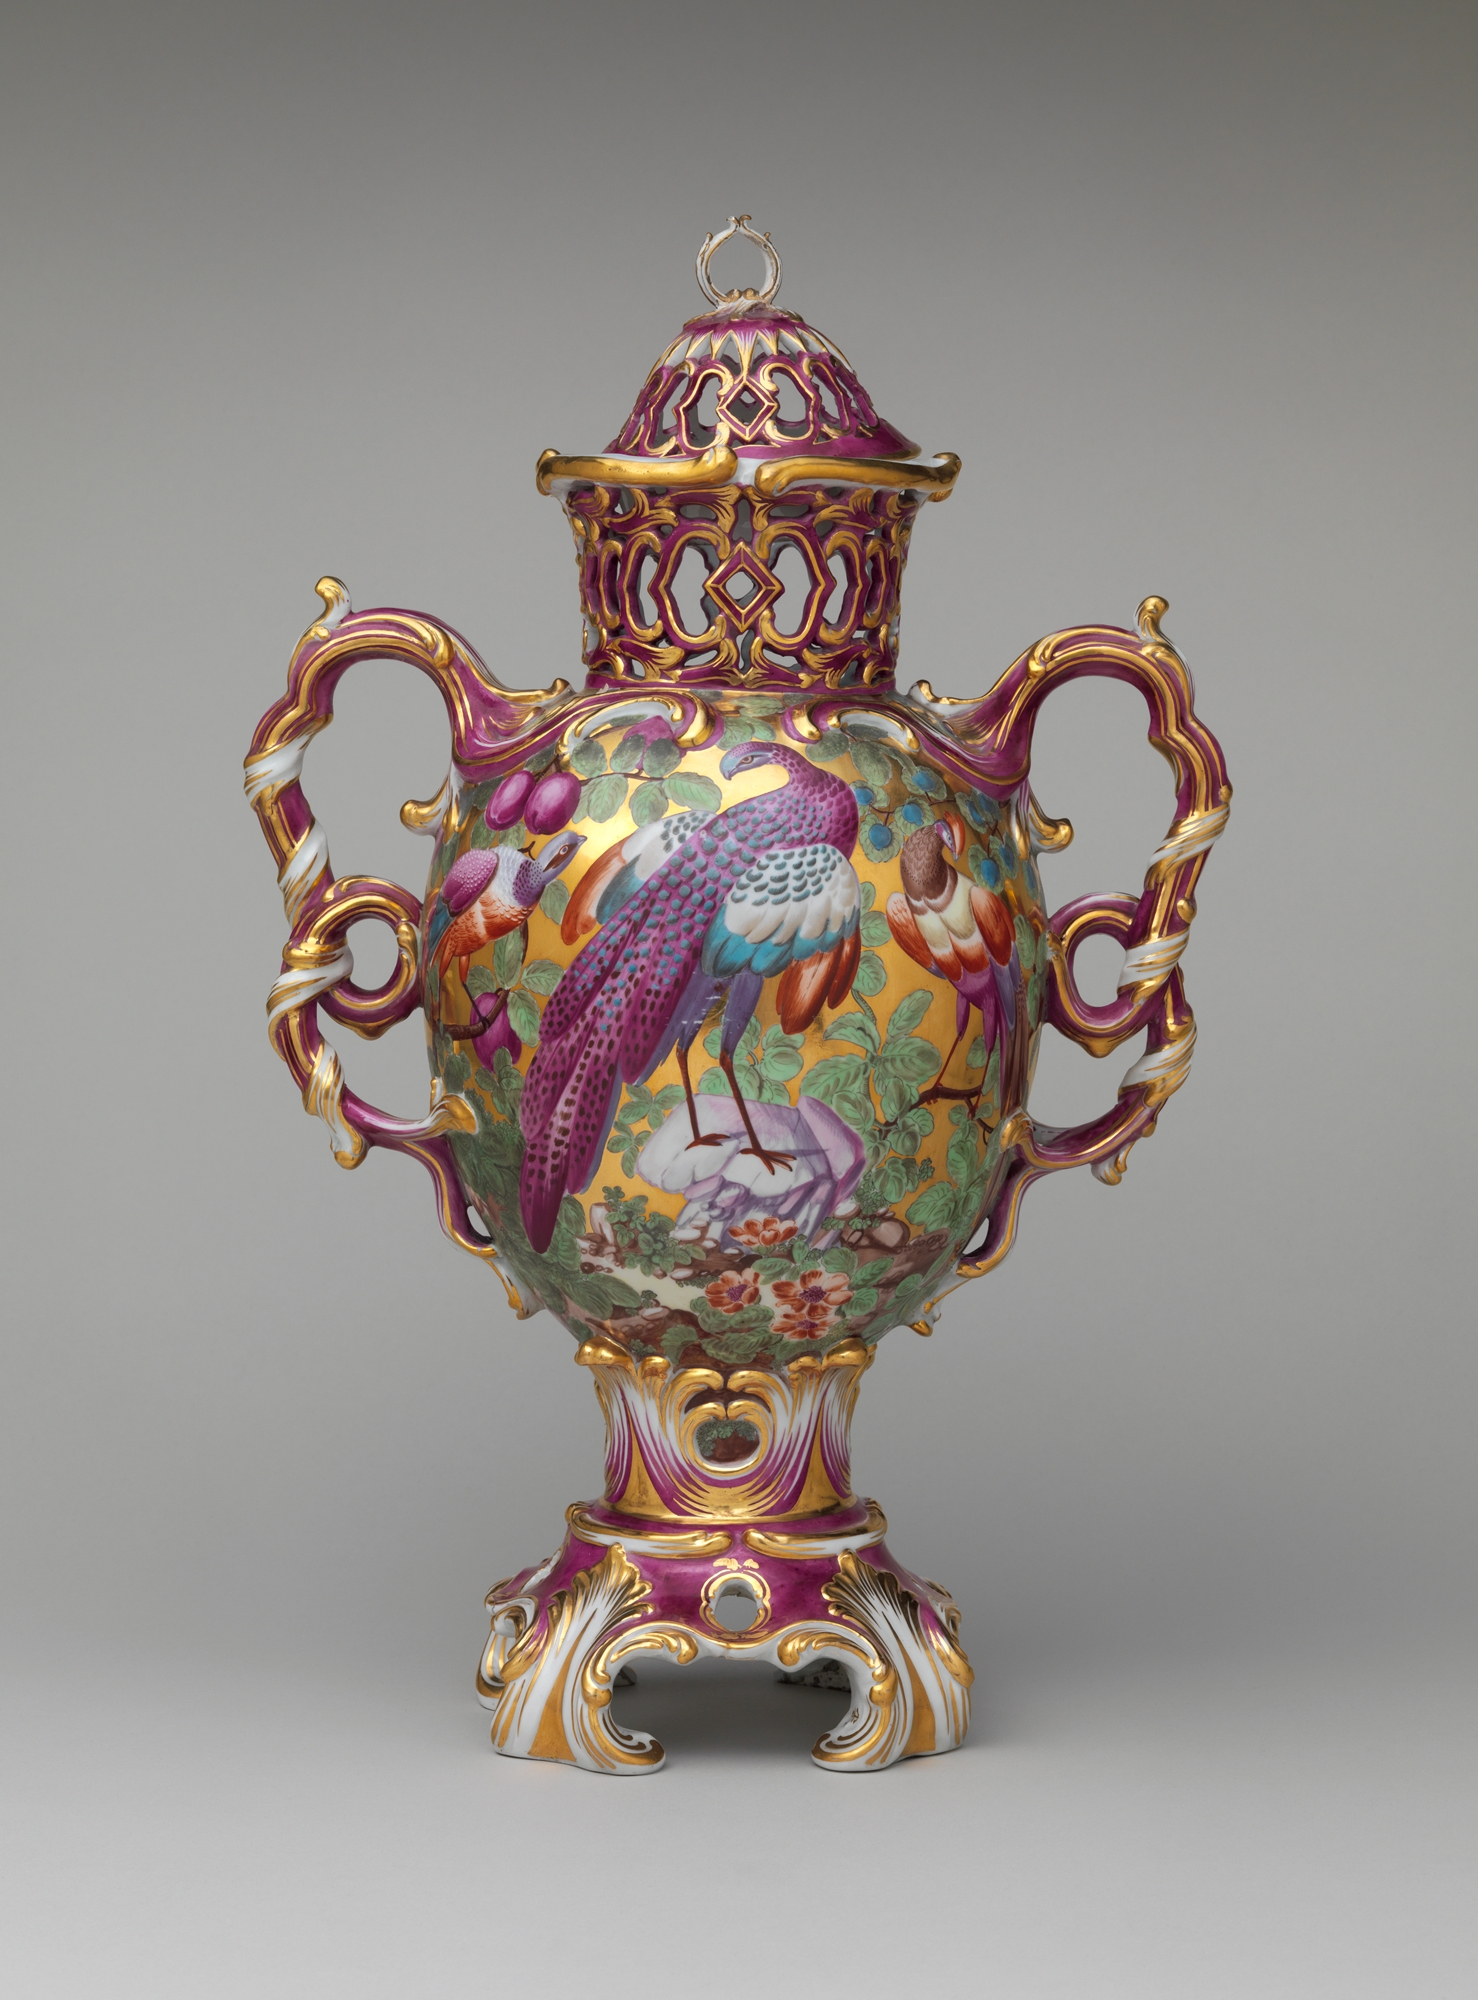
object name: perfume vase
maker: chelsea porcelain manufactory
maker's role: factory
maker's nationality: british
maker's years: 1744-1784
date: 1761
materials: soft paste porcelain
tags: birds